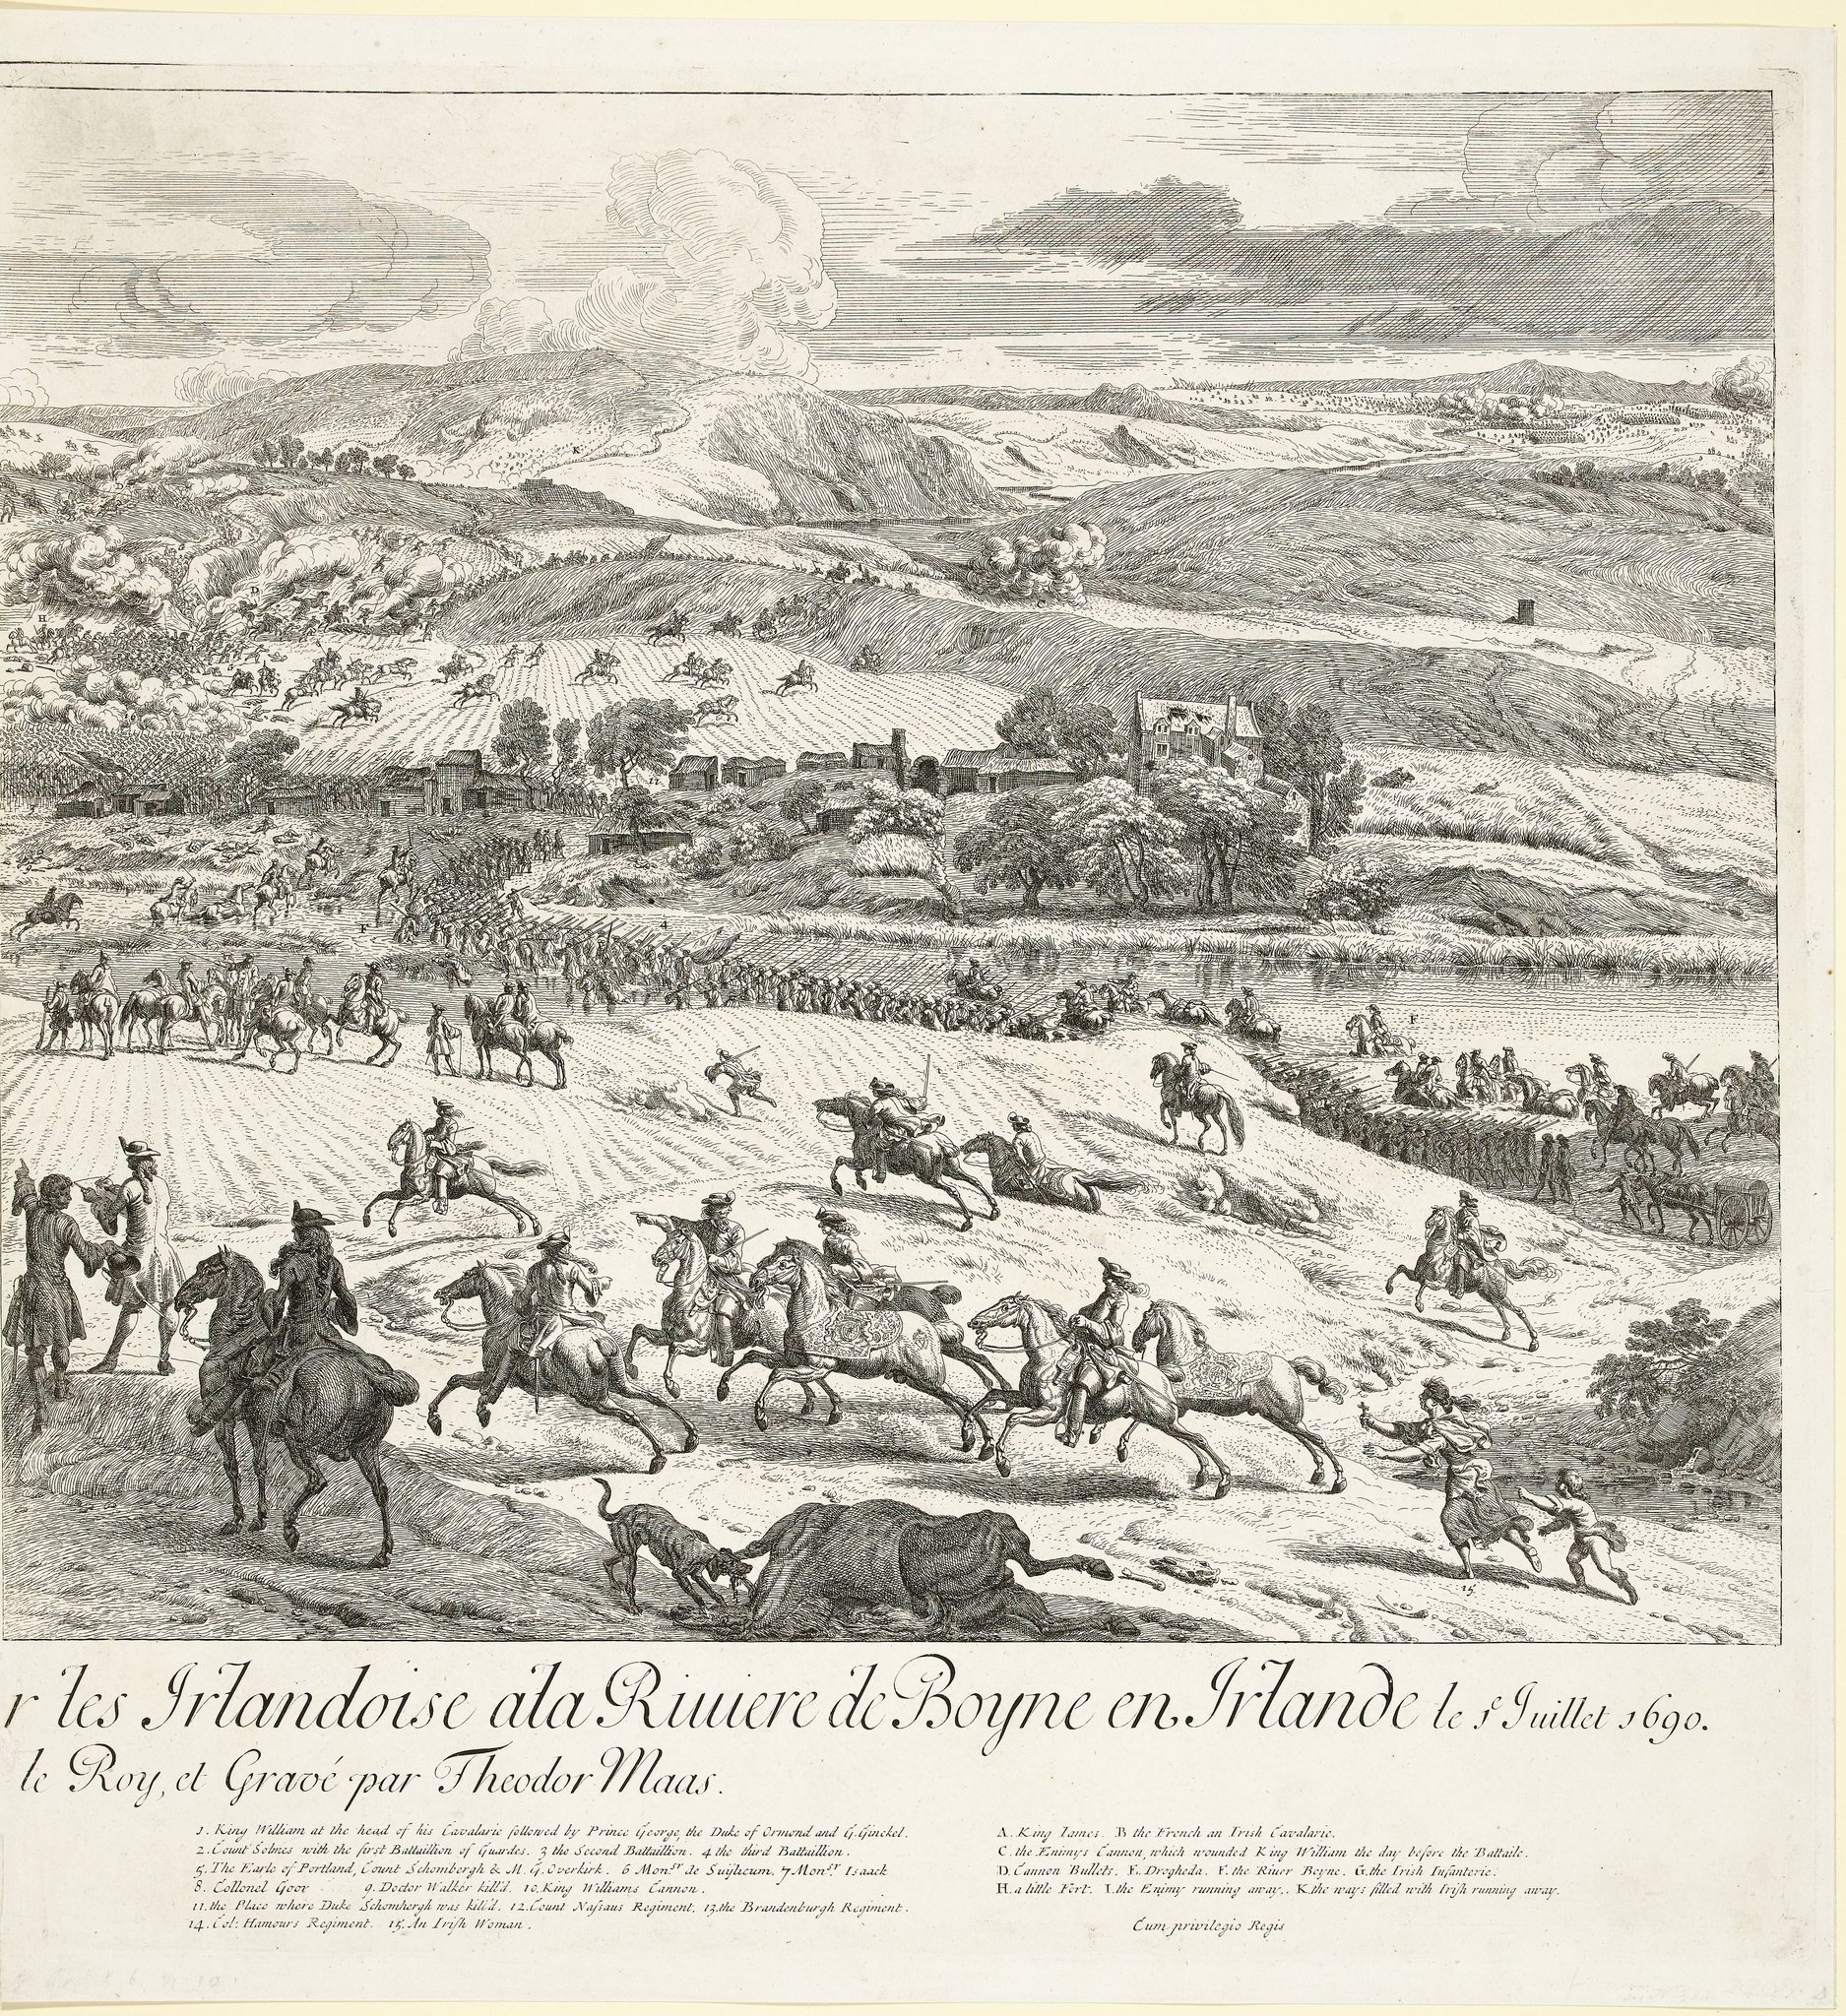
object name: print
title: Overwinning van koning Willem III aan de Boyne (rechterblad), 1690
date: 1690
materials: paper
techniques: etching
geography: england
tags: jacobus ii (koning van engeland en schotland), the hague, william iii (prince of orange and king of england, scotland, and ireland), haarlem, print maker, draughtsman, dirk maas, battle (+ naval force)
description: Rechterblad van een grote voorstelling op twee losse bladen van de slag bij de rivier de Boyne op 11 juli 1690, waarbij het leger van Willem III een overwinning behaalt op de katholieken onder Jacobus II. Op de voorgrond links de kunstenaar tekenend. In het onderschrift de legenda's 1-16 en A-K in het Frans en Engels.